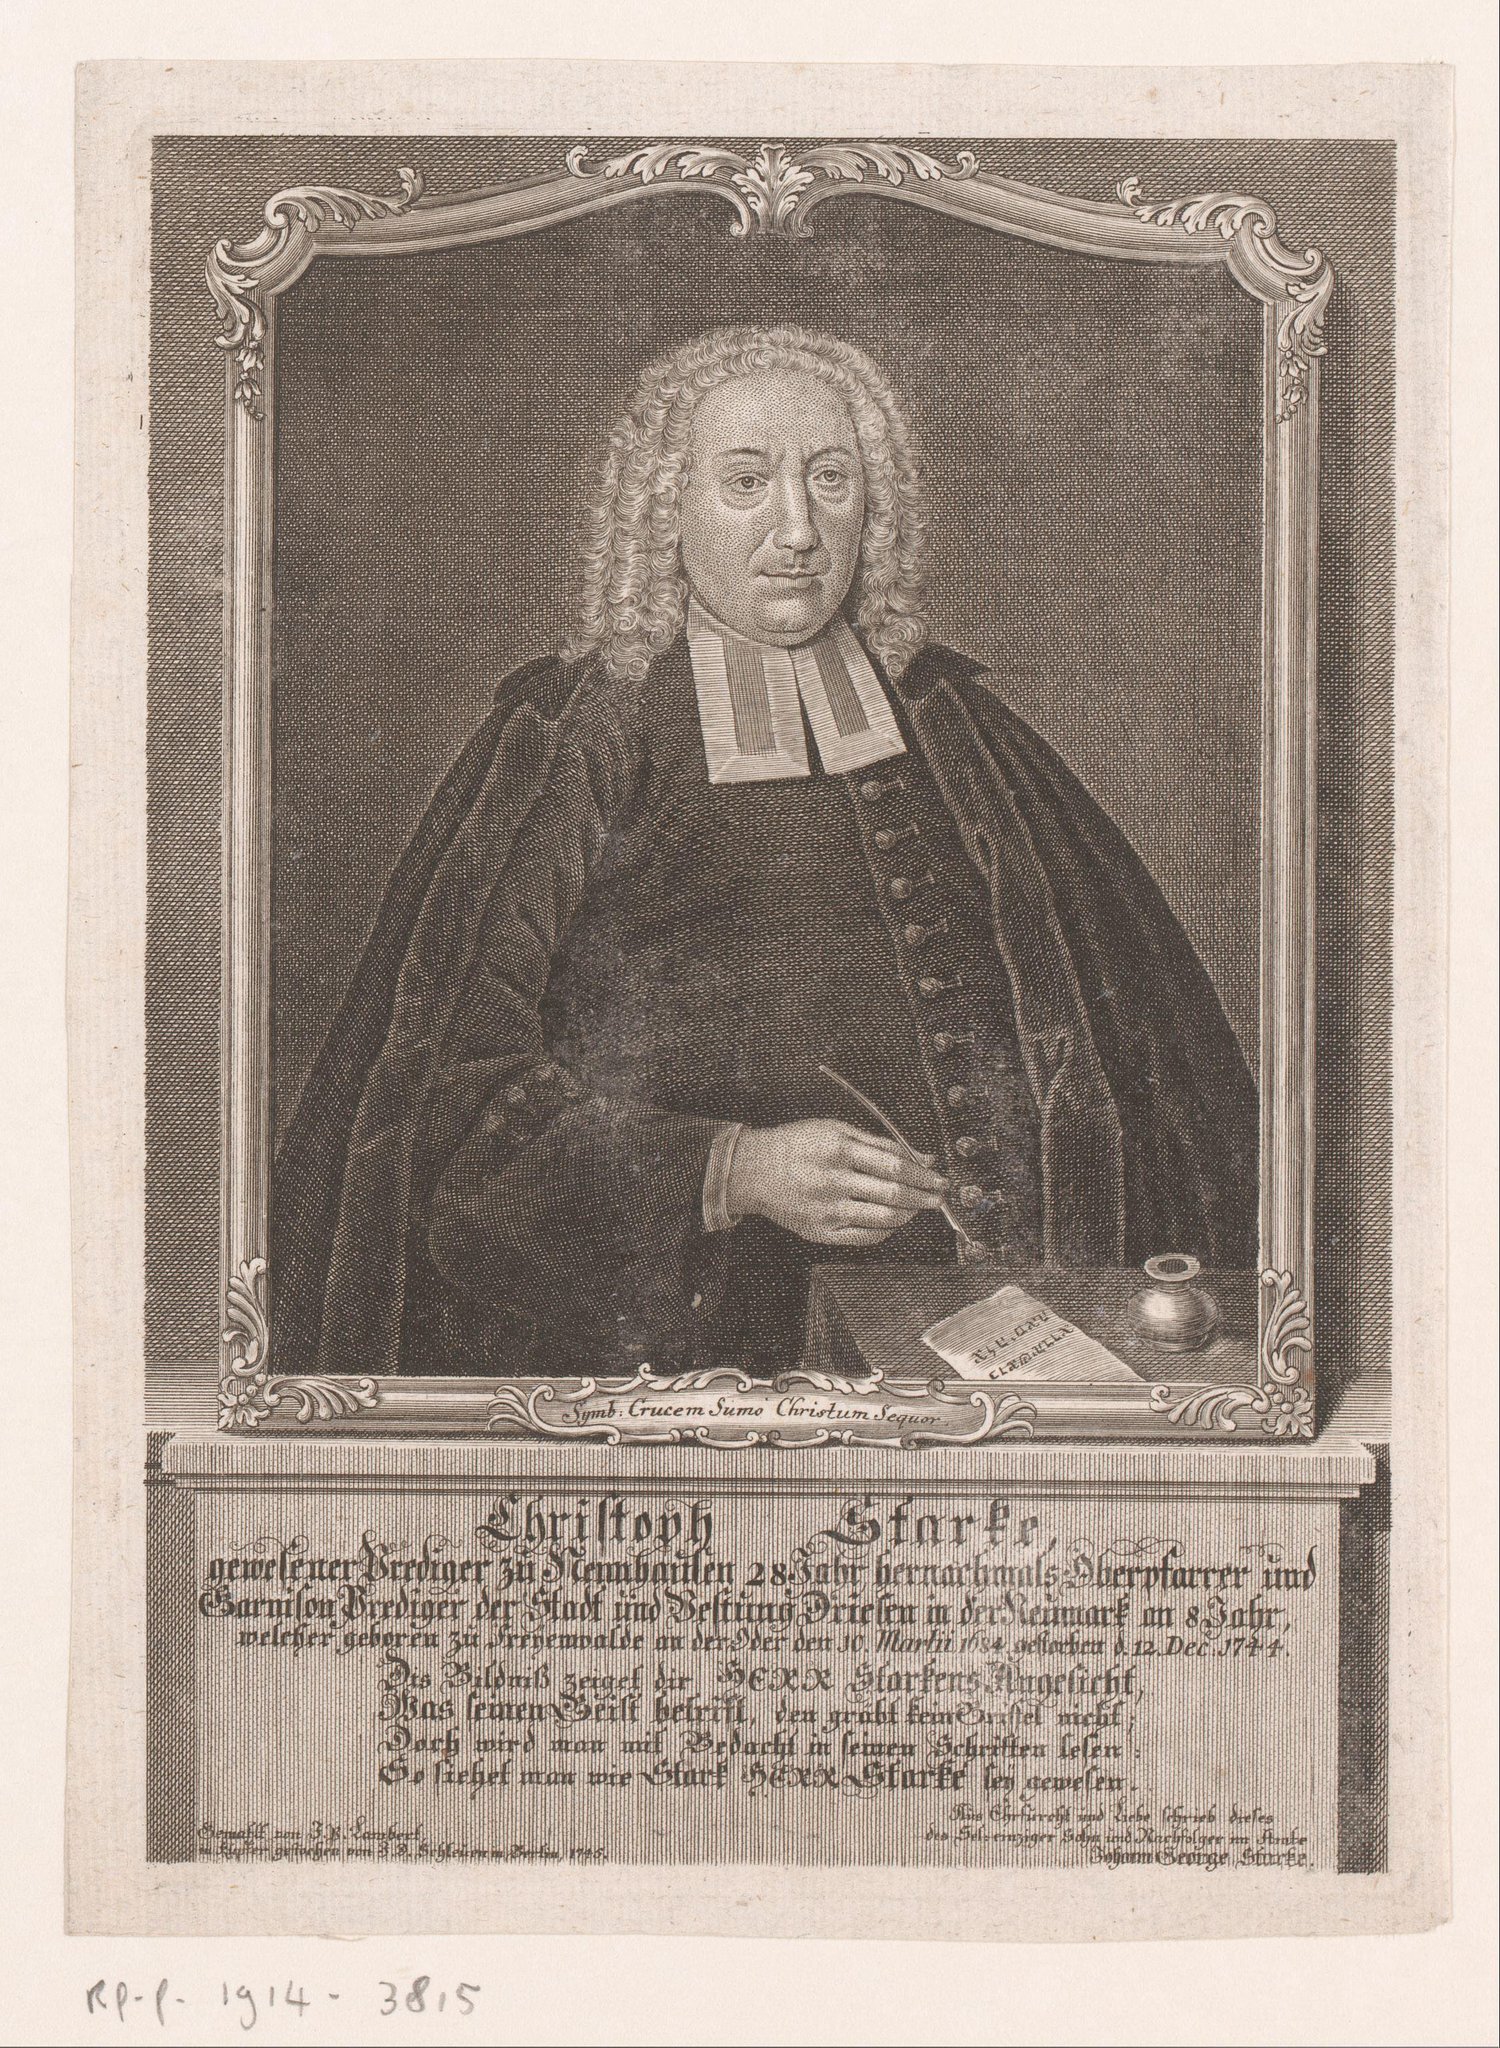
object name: print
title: Portret van Christoph Starke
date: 1745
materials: paper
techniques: engraving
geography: berlin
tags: historical persons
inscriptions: collector's mark: Lugt 2228